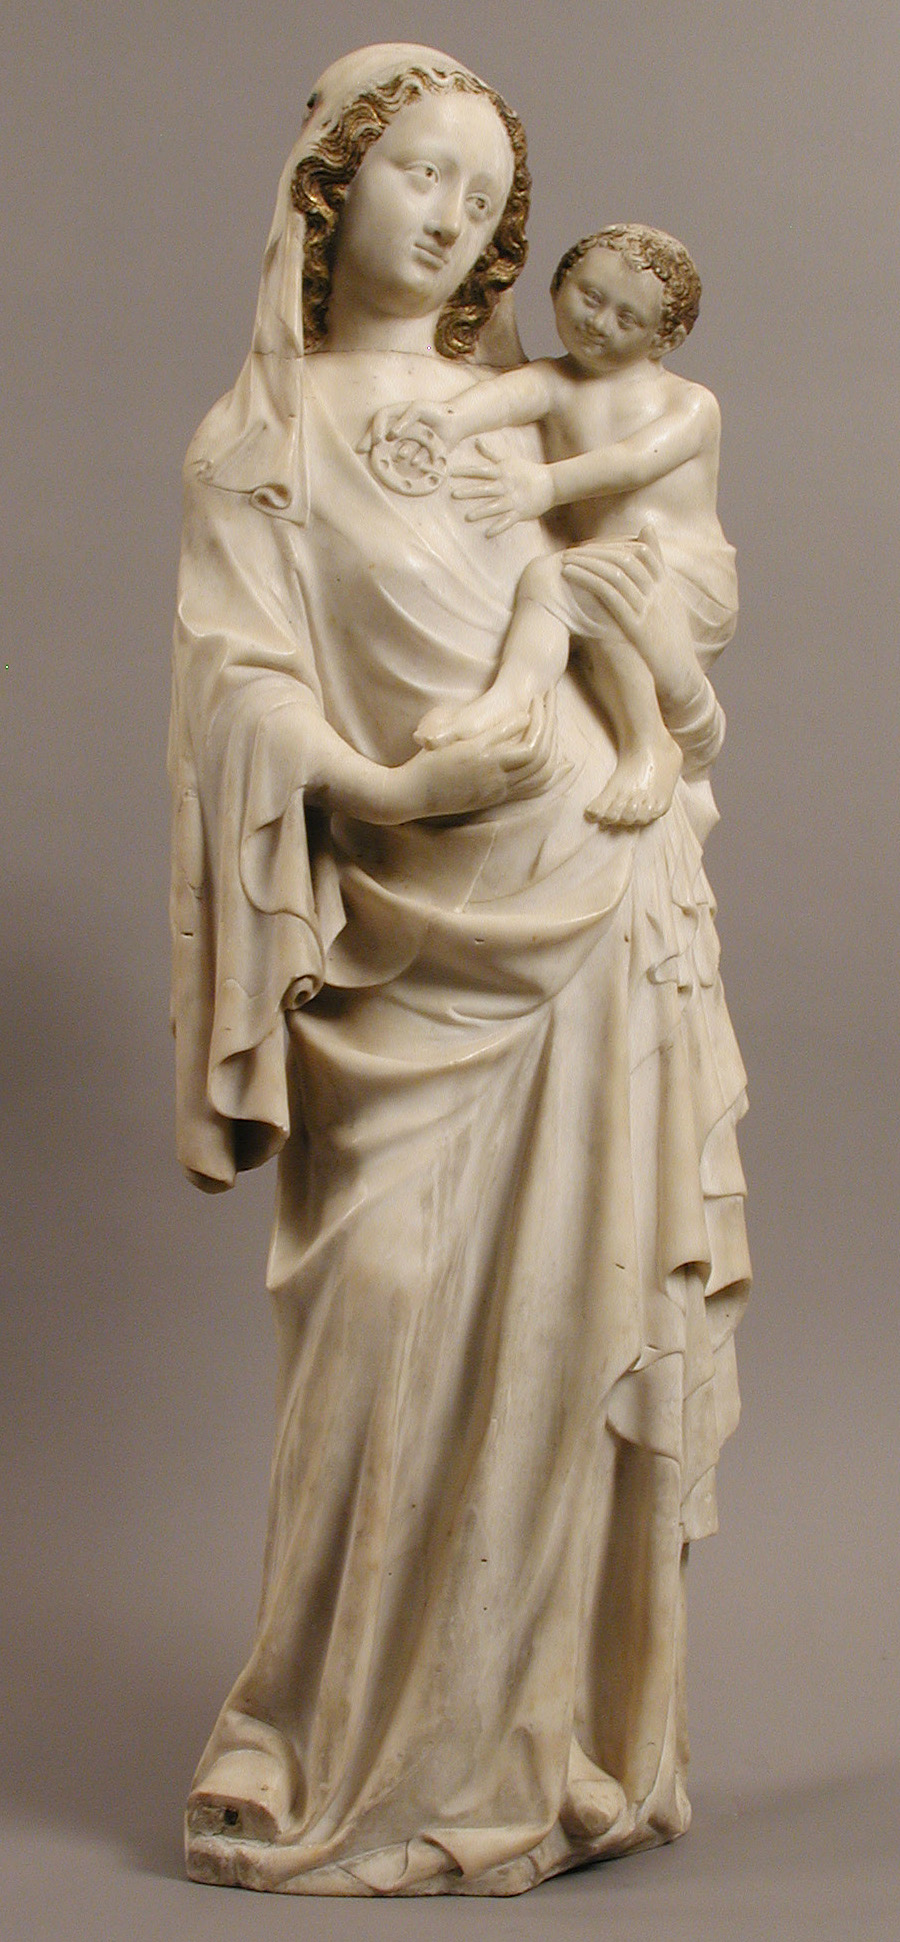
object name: statuette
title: Virgin and Child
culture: french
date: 1301-1400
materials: marble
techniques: gilding, polychromy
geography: france